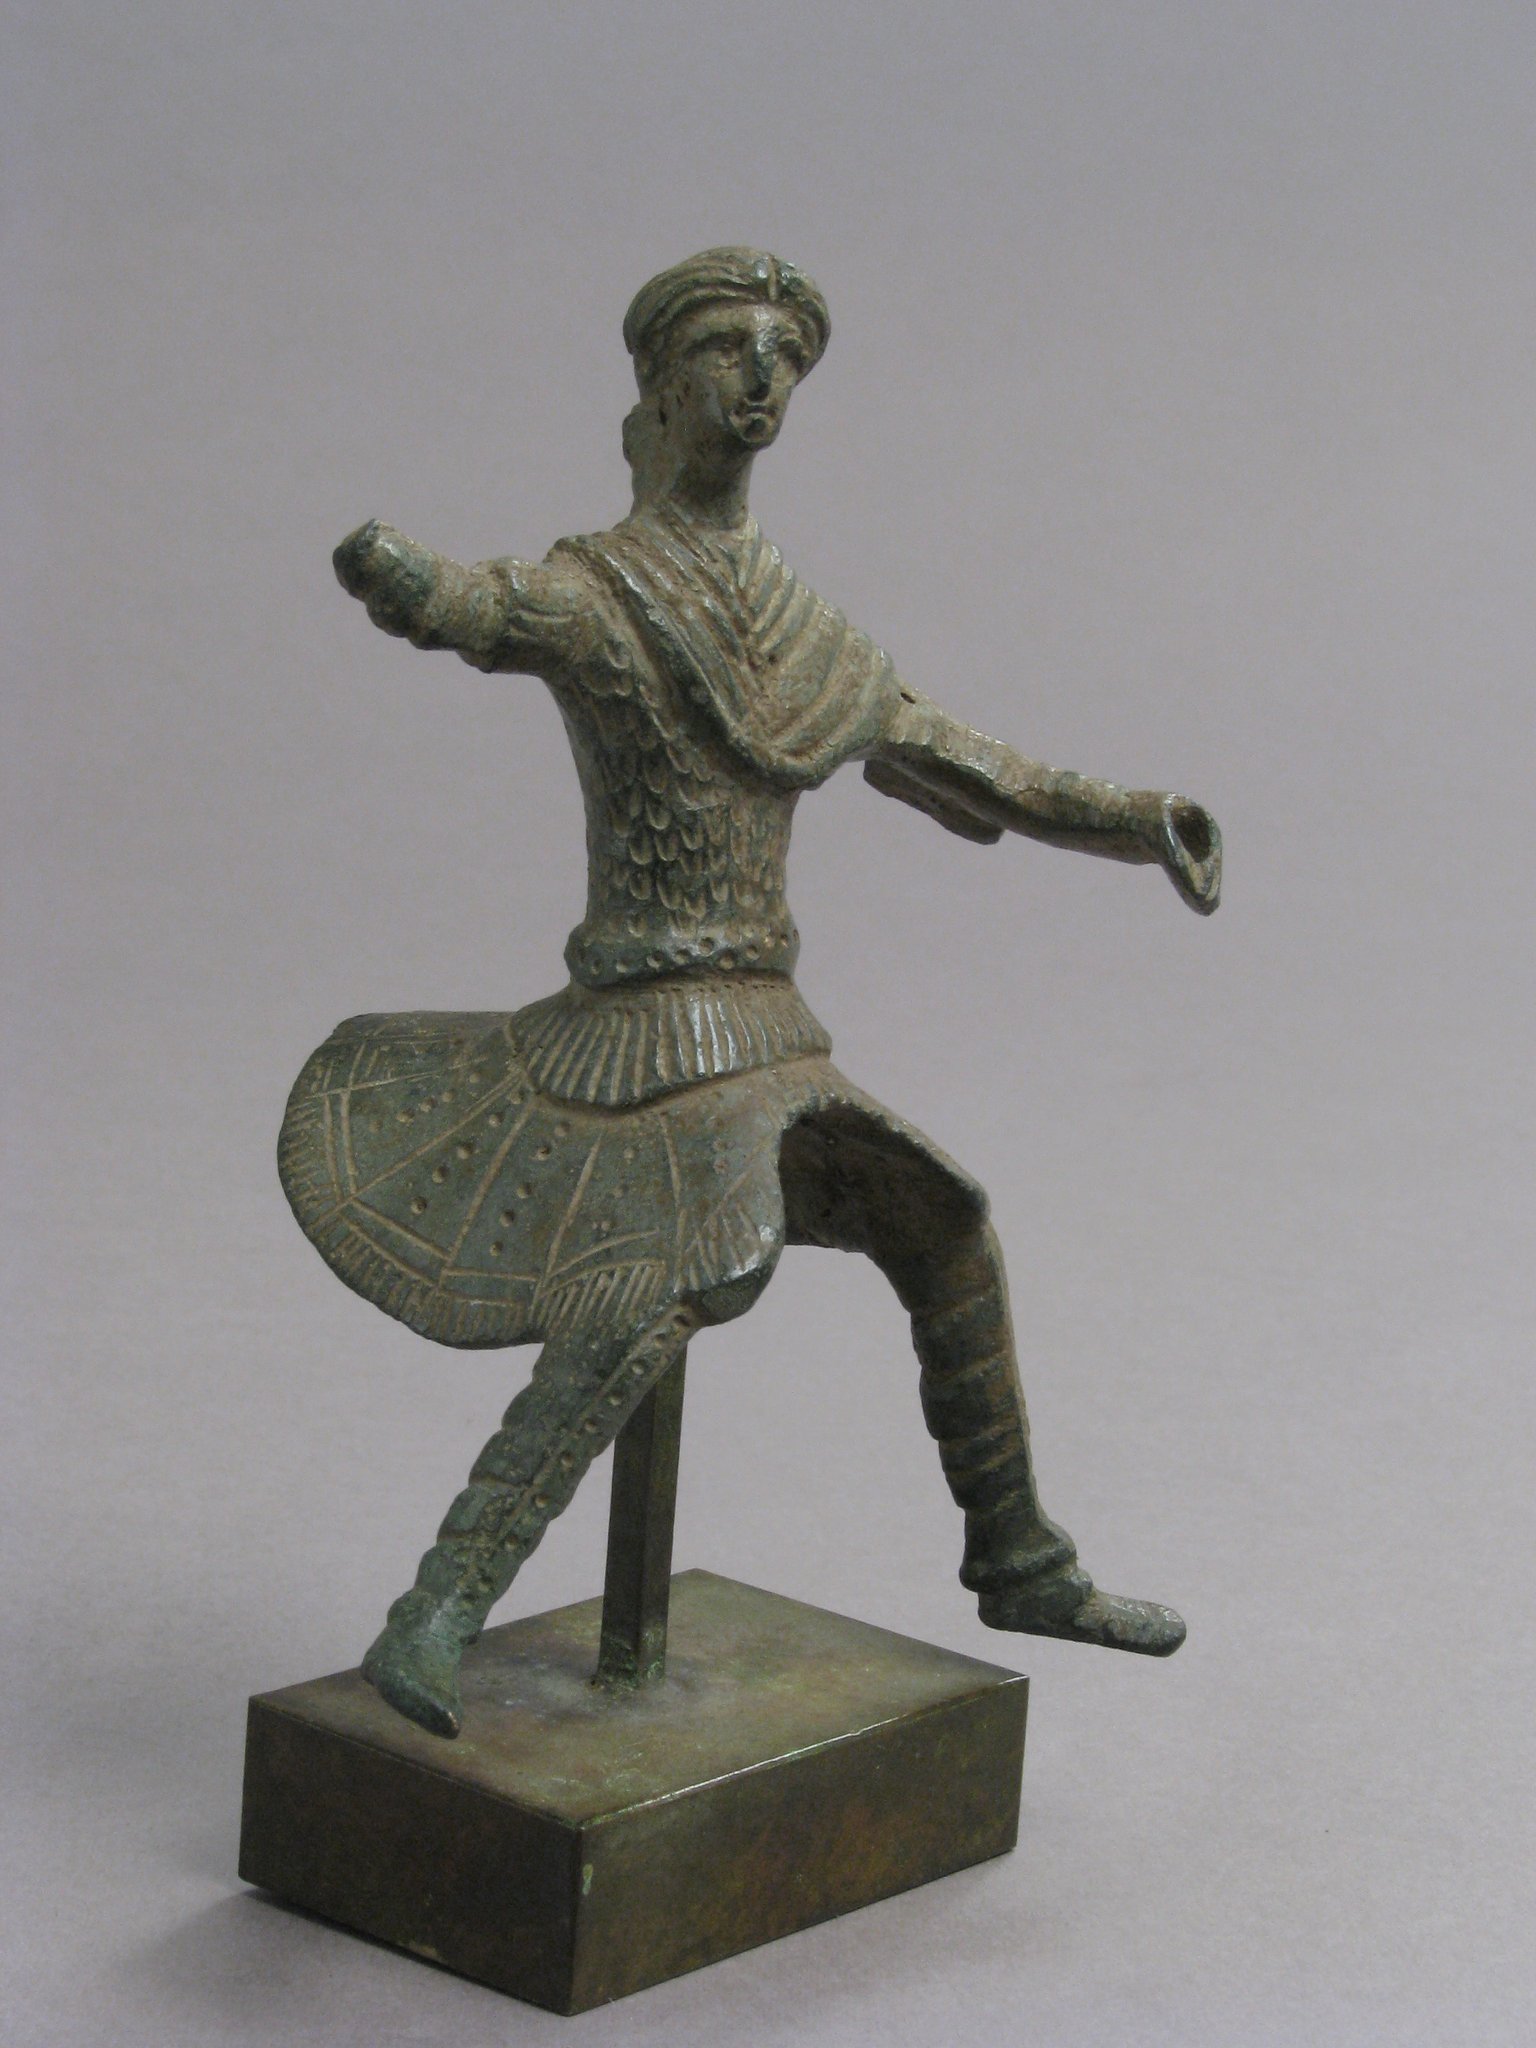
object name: figure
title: Warrior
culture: byzantine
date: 301-500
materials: copper alloy